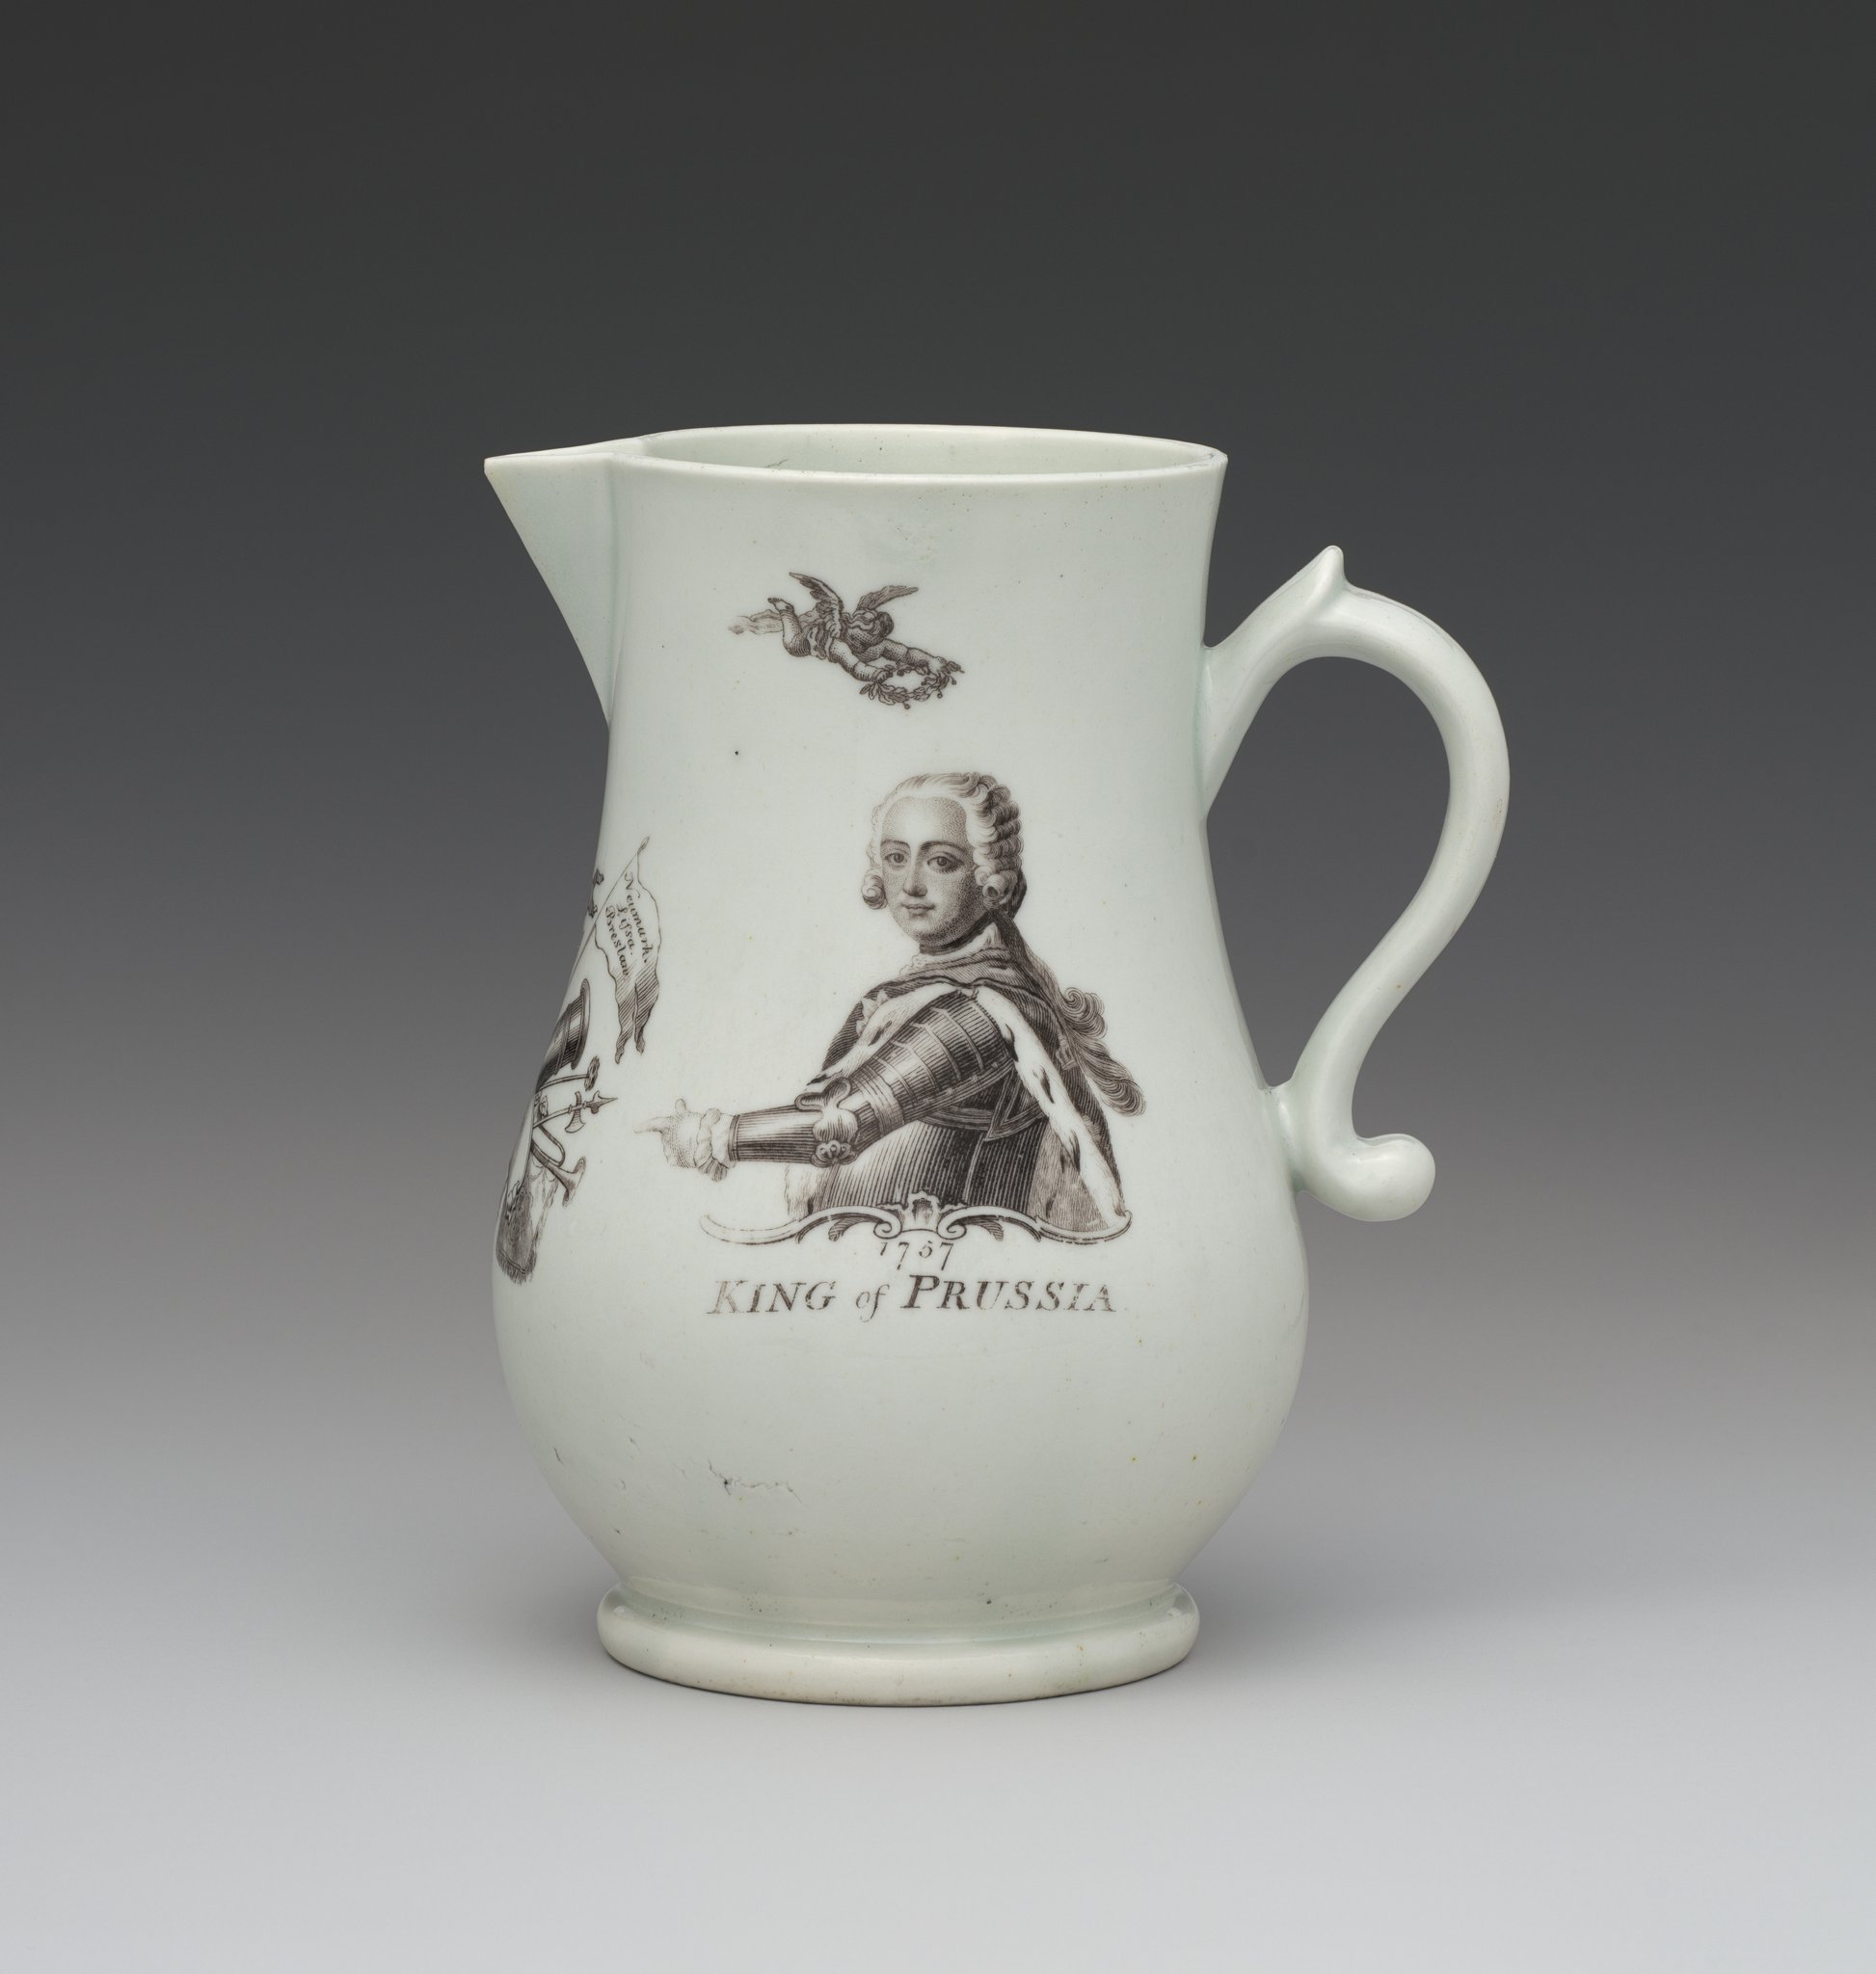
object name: jug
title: Jug with portrait of Frederick the Great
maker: worcester factory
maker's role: manufactory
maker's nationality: british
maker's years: 1751-2008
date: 1757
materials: soft paste porcelain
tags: kings,cupid